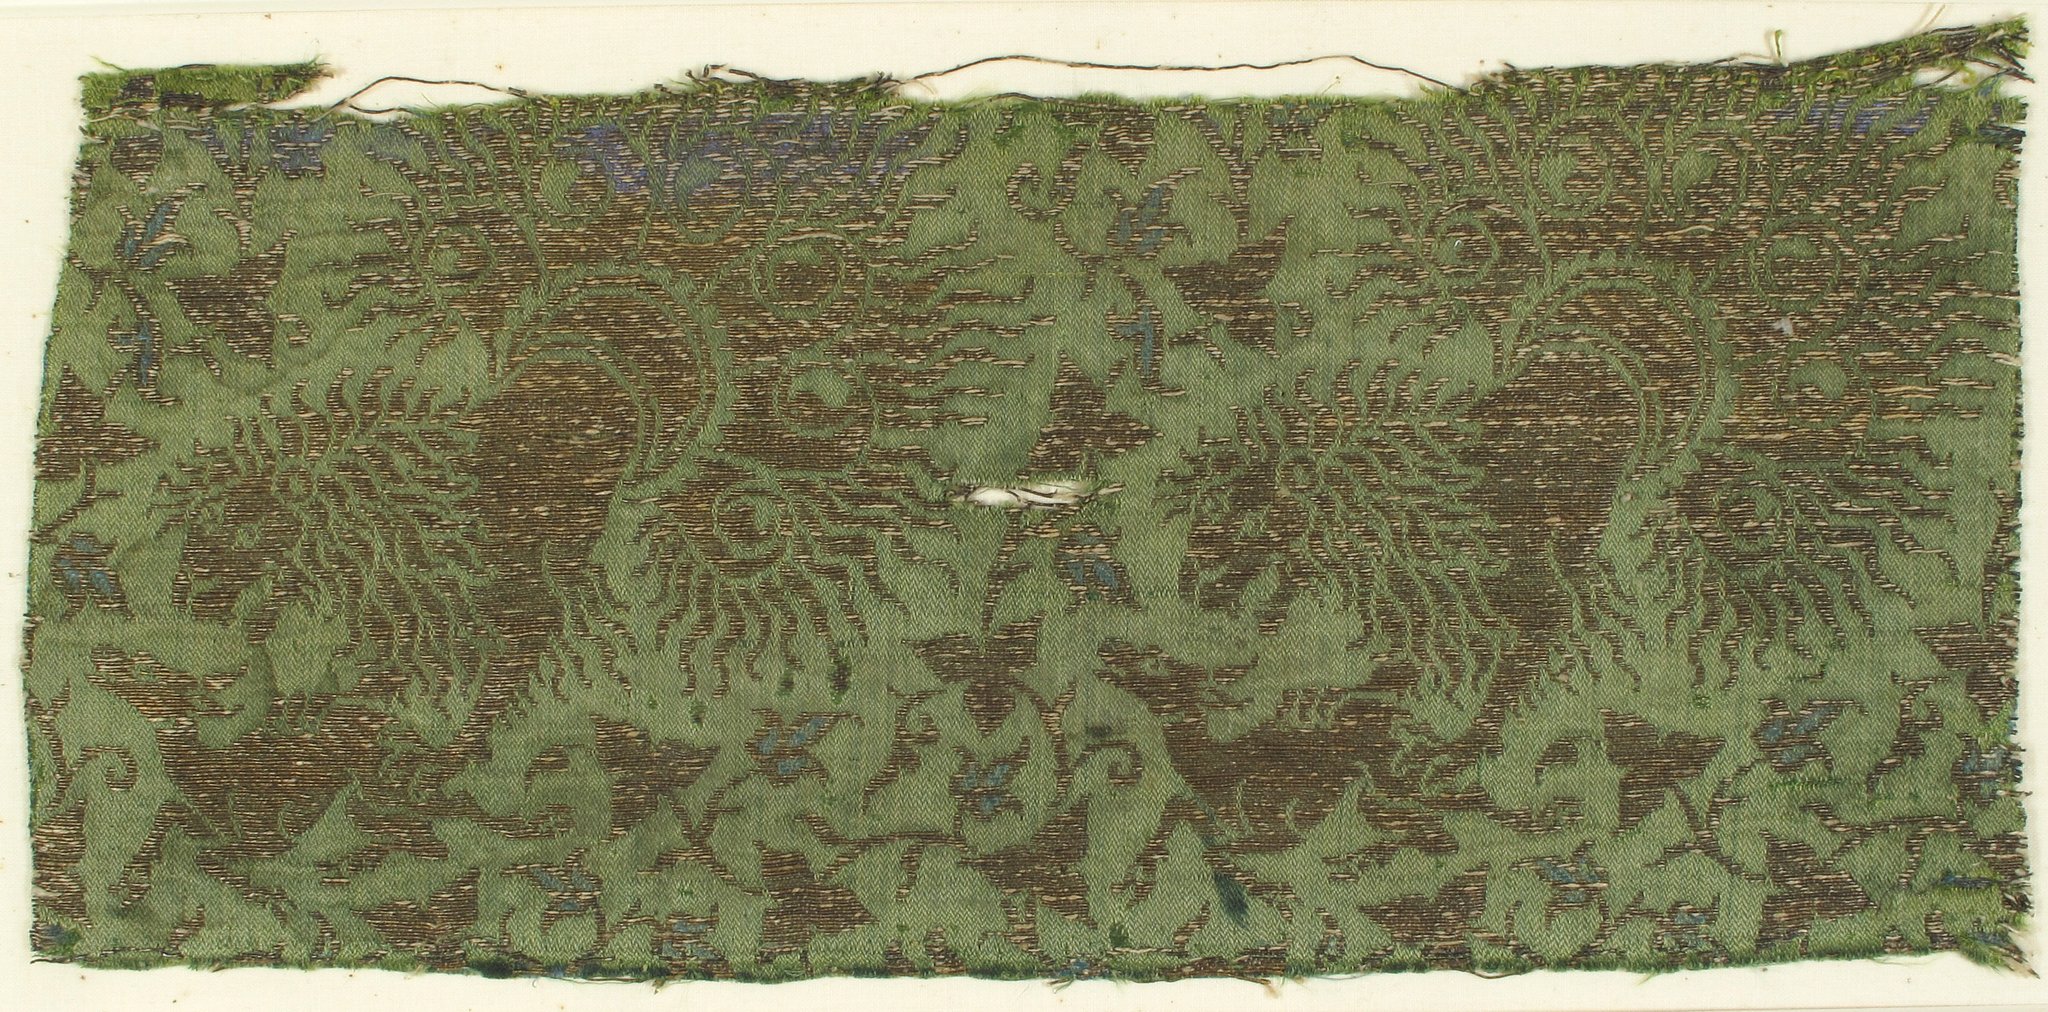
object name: textile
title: Textile with Lions, Gazelles and Foliage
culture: italian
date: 1301-1400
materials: metal thread, silk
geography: italy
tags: lions